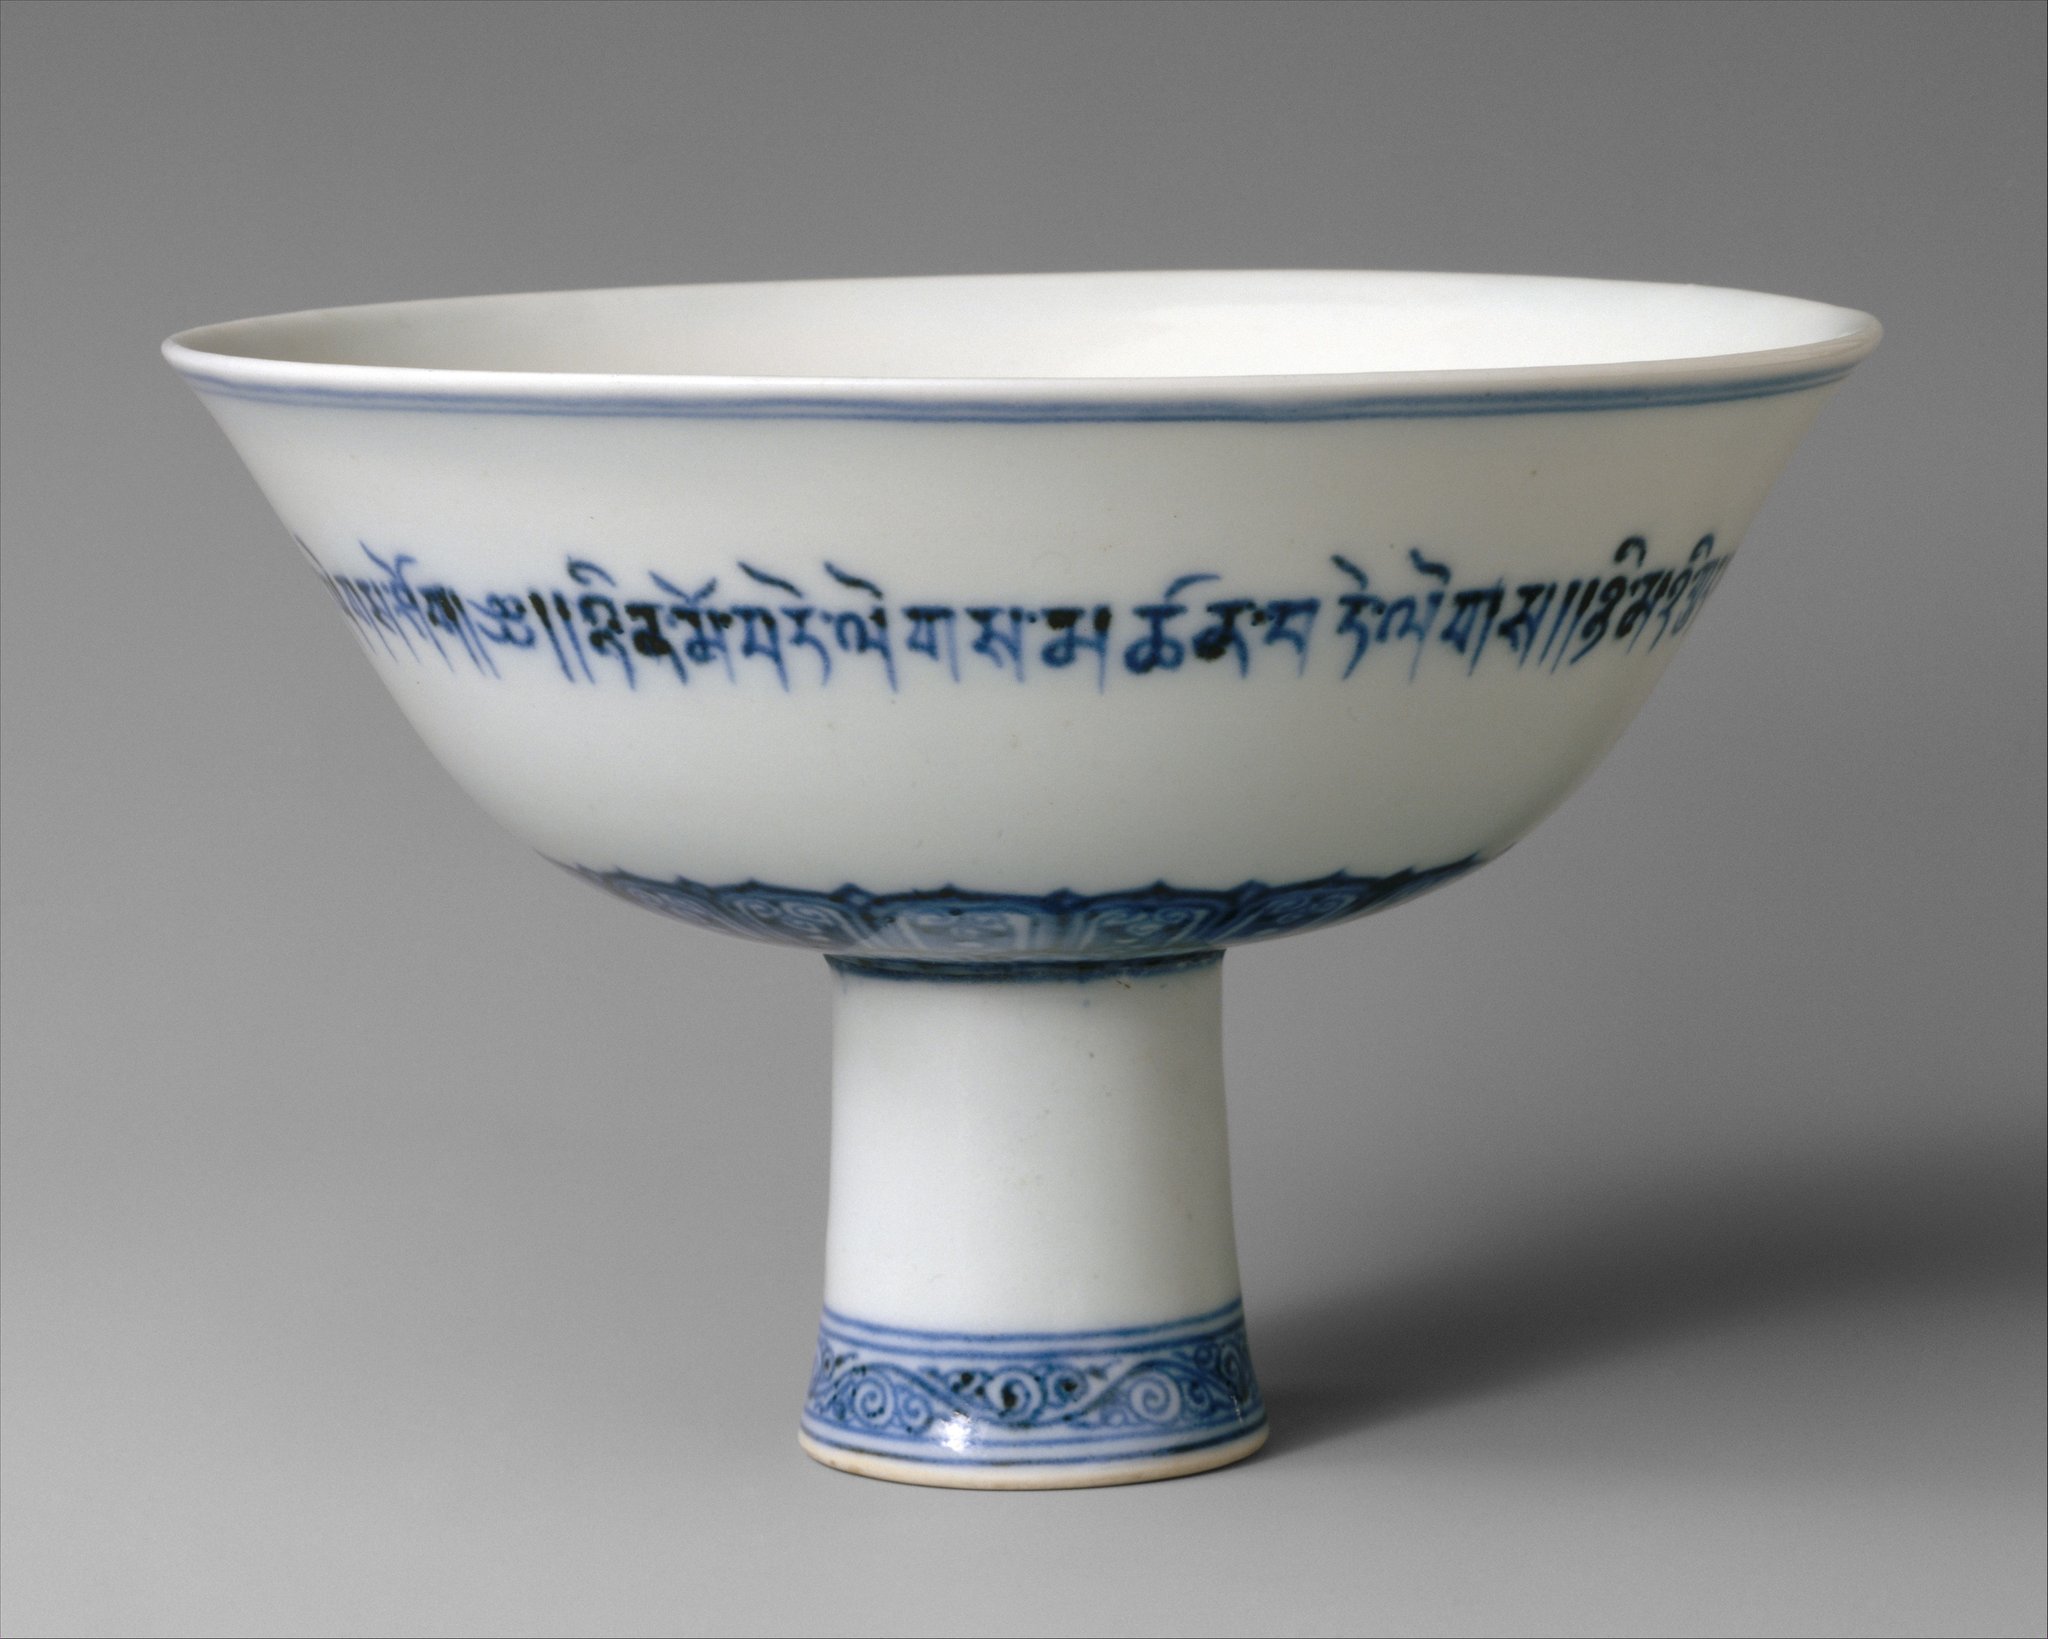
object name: altar bowl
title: Altar bowl with Tibetan inscription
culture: chinese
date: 1401-1433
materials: cobalt, glaze, porcelain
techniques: incising, painting